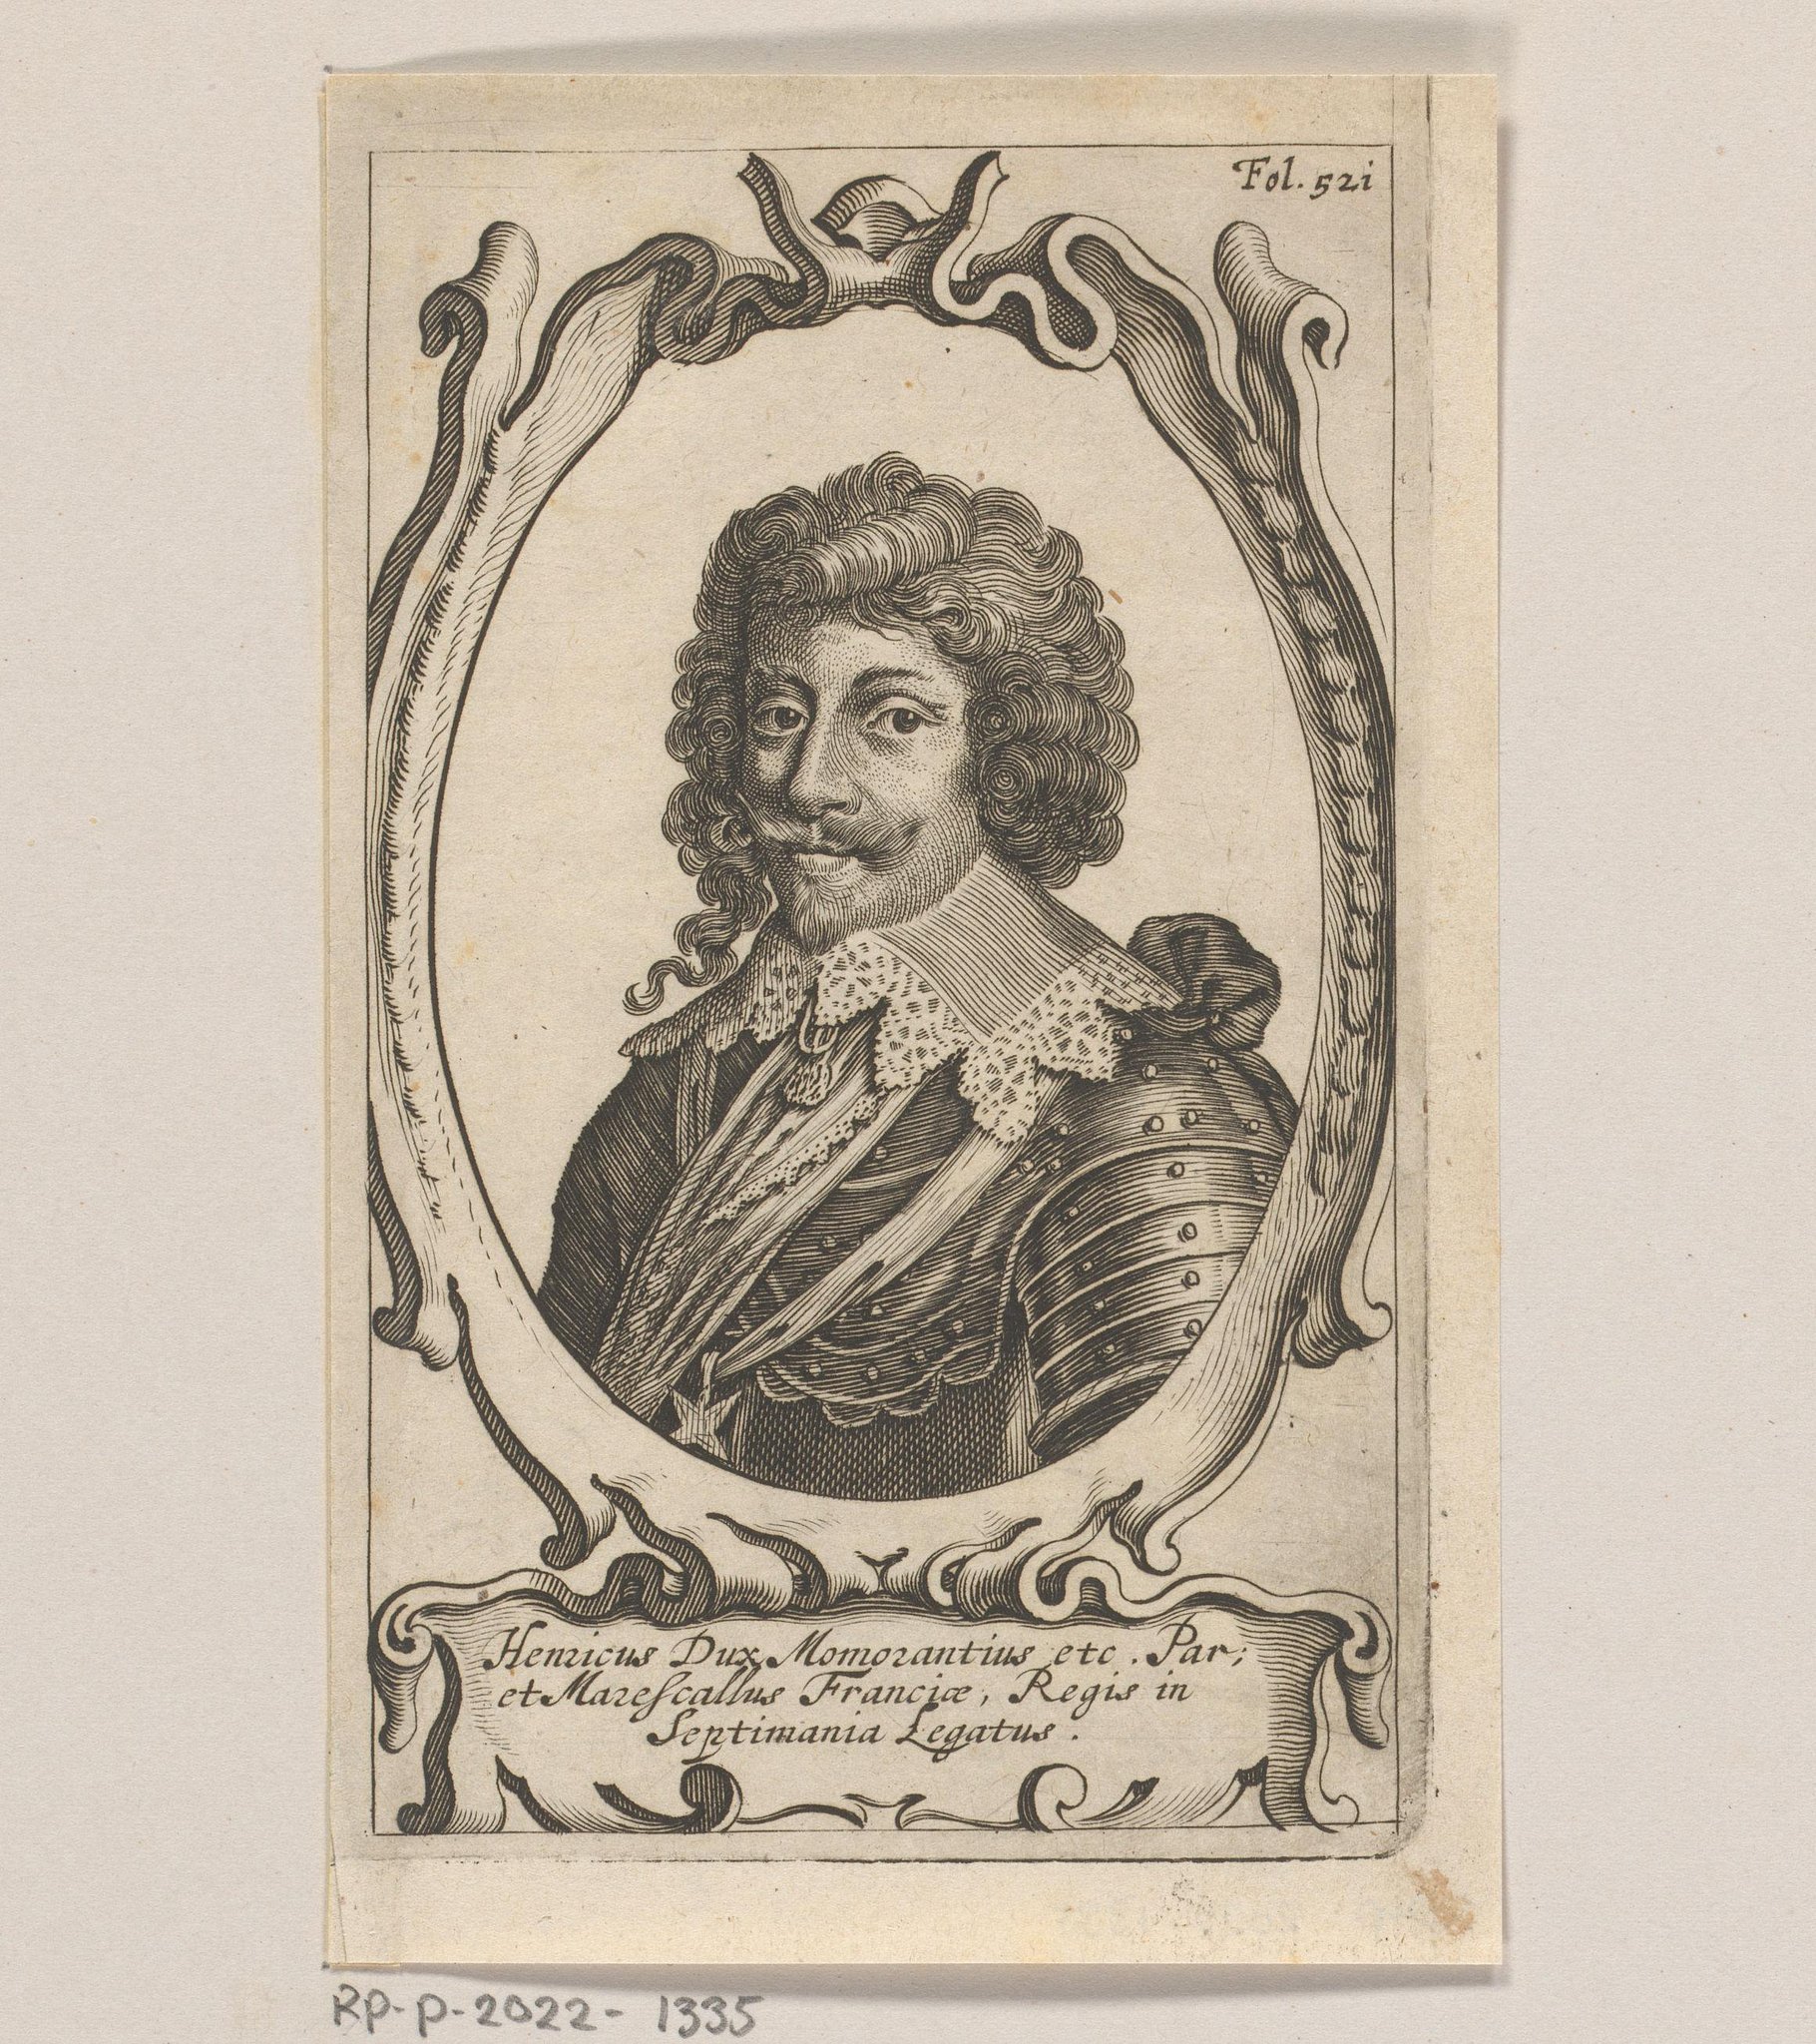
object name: book illustration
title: Portret van Henry duc de Montmorency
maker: Anonymous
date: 1600-1750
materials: paper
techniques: engraving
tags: chantilly, ranks in the army, historical persons